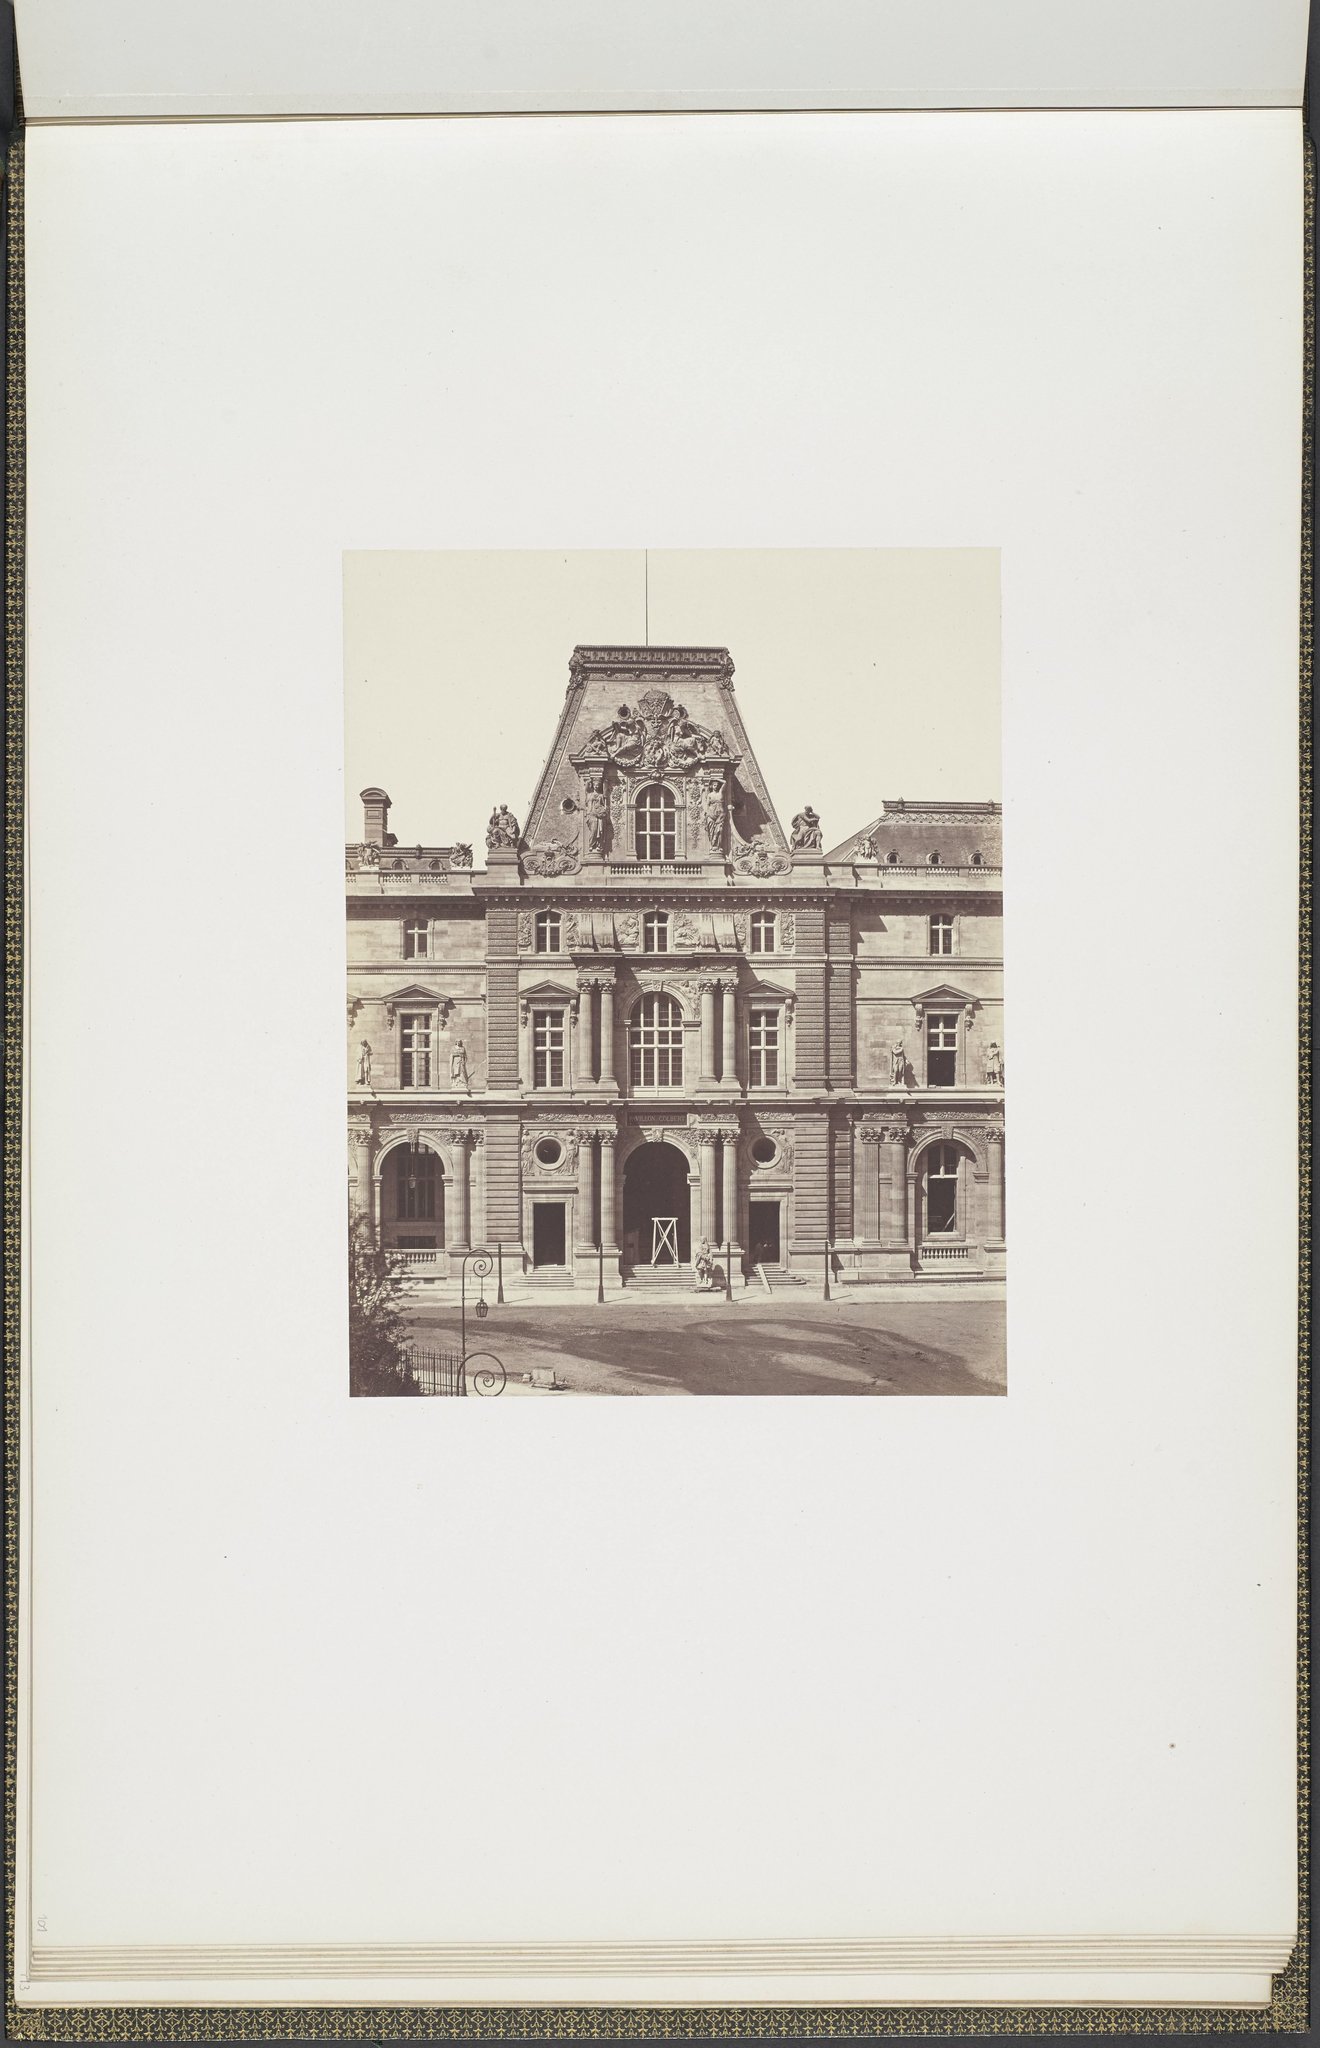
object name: album leaf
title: Pavillon Colbert in het Palais du Louvre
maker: édouard denis baldus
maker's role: fotograaf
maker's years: 1813-1889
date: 1857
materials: paper, photographic support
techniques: salted paper print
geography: paris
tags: permanent exhibition, museum, façade (of house or building), paris, tuileries palace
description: Onderdeel van Réunion des Tuileries au Louvre 1852-1857, album 1.